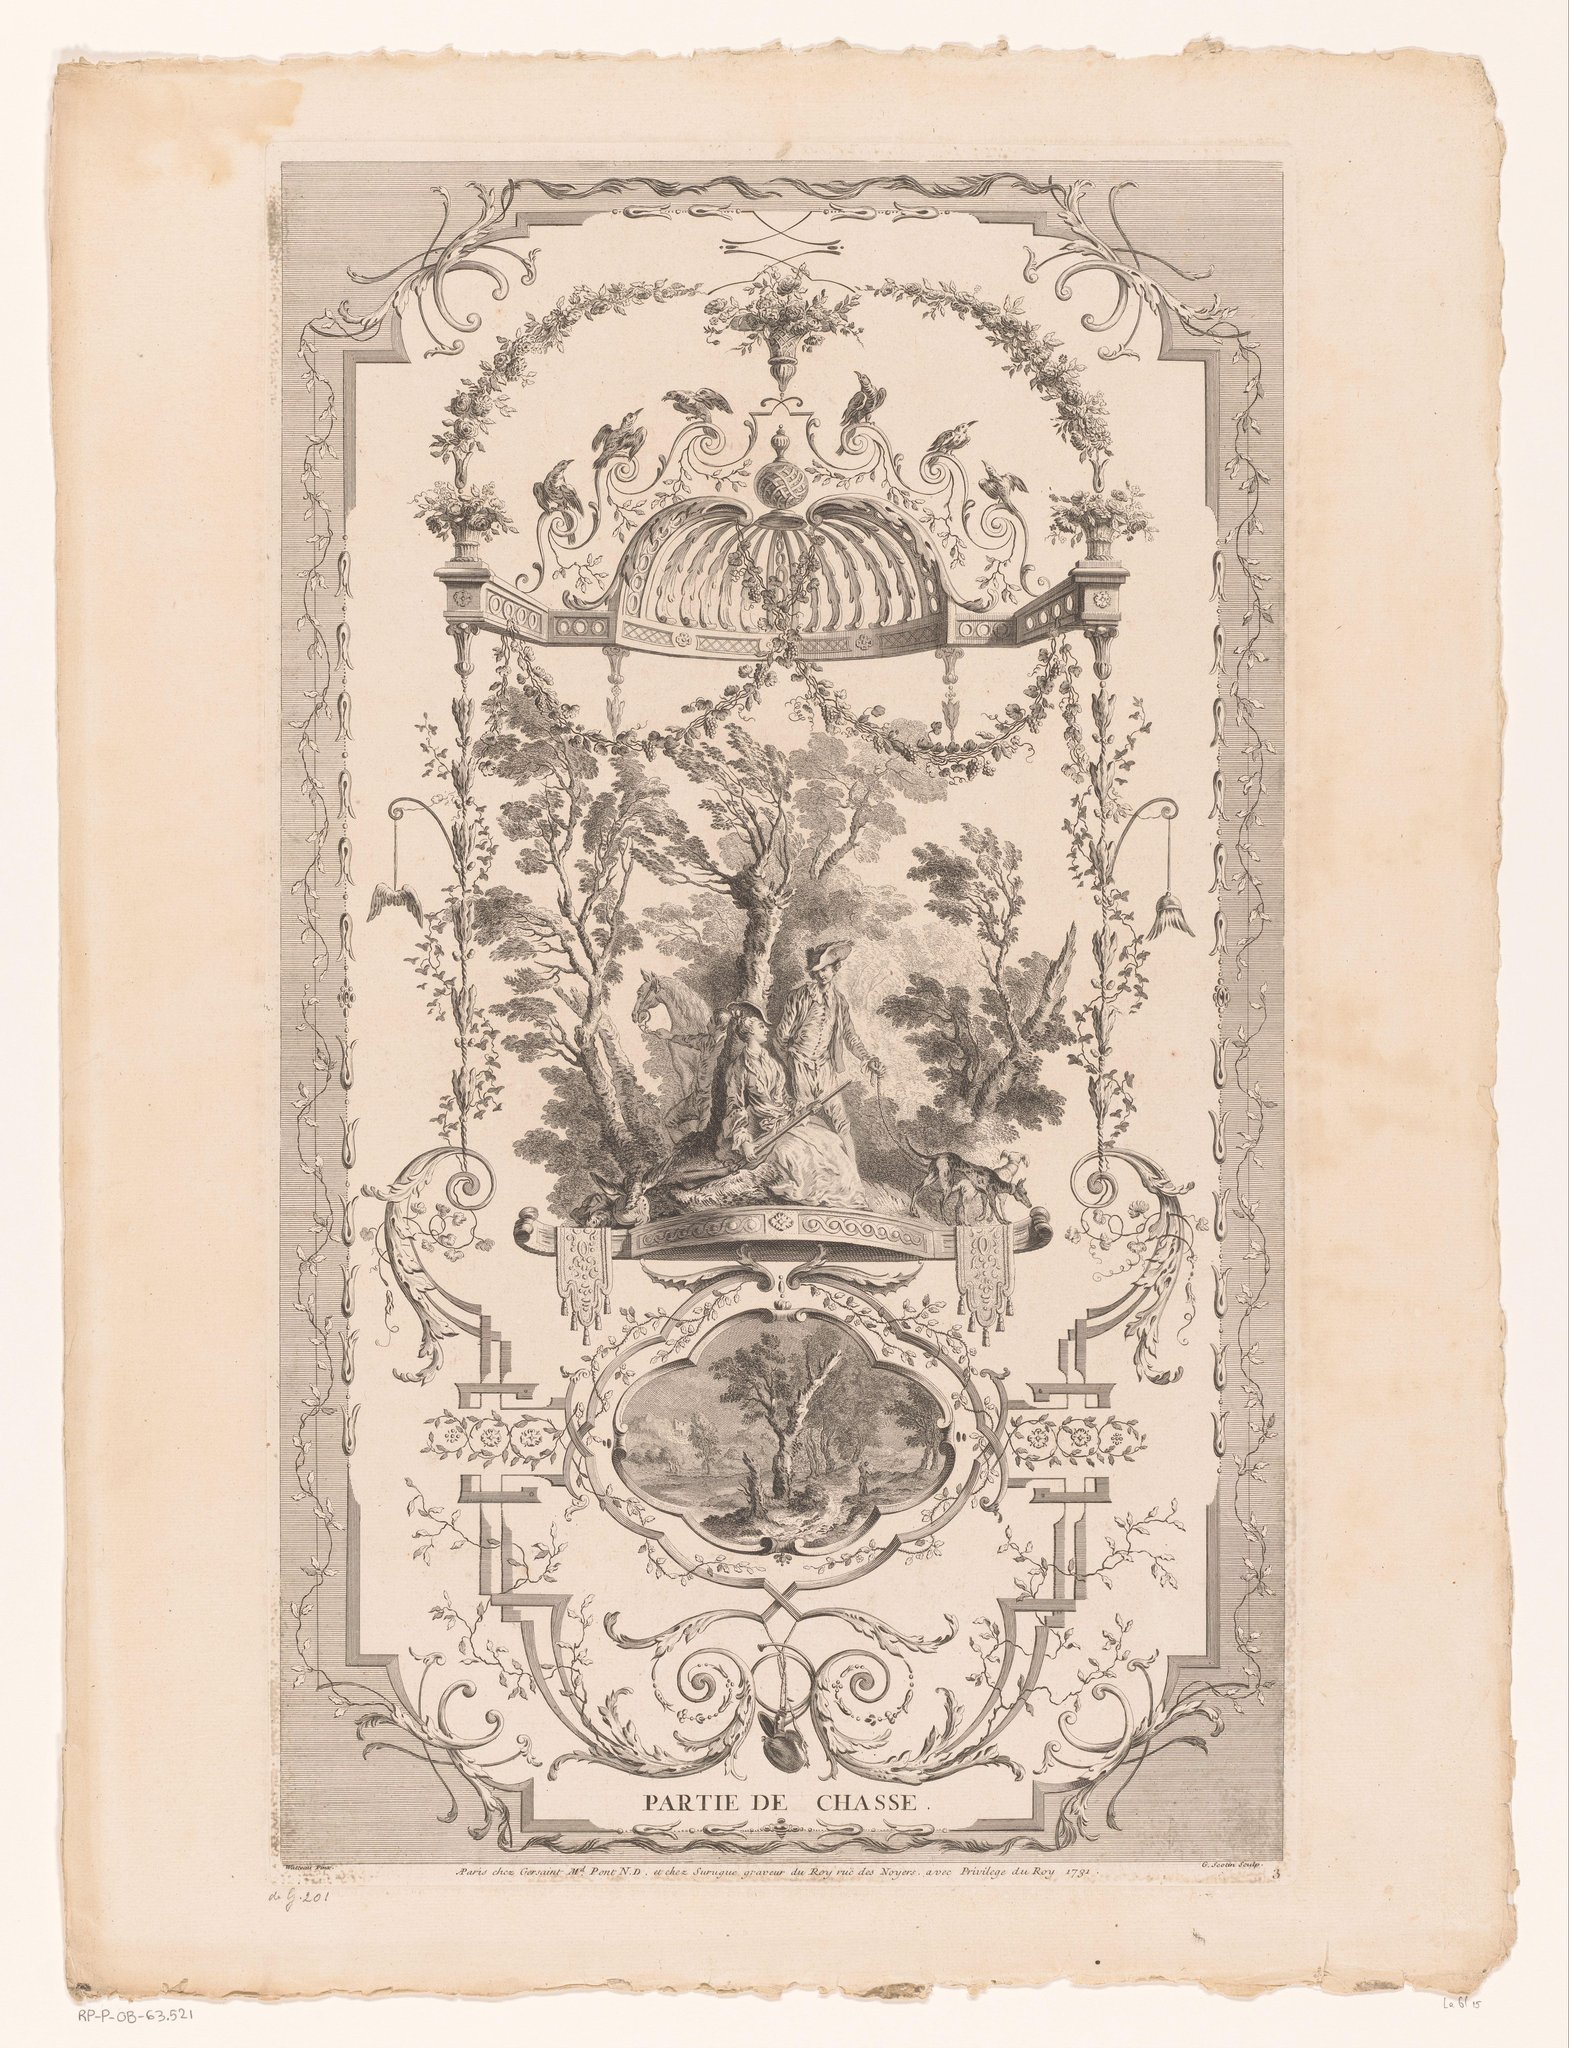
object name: print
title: Jachttafereel omringd door florale ornamenten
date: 1731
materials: paper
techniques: engraving, etching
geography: paris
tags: hunting, chase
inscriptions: date